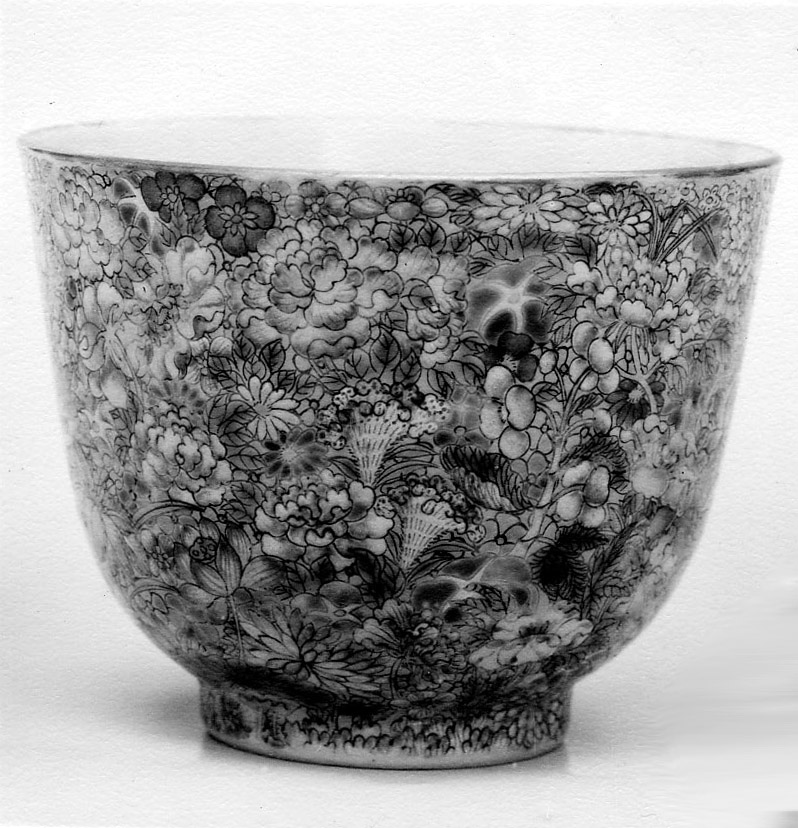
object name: cup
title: One of a Pair of Cups with Mille-Fleurs Design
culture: chinese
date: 1796-1820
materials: enamel, porcelain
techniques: overglaze, painting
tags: flowers